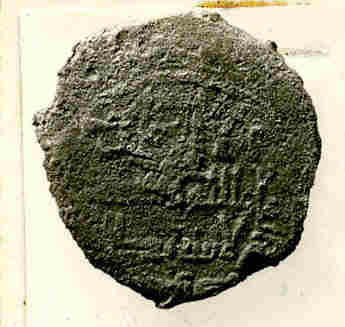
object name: coin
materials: copper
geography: iran